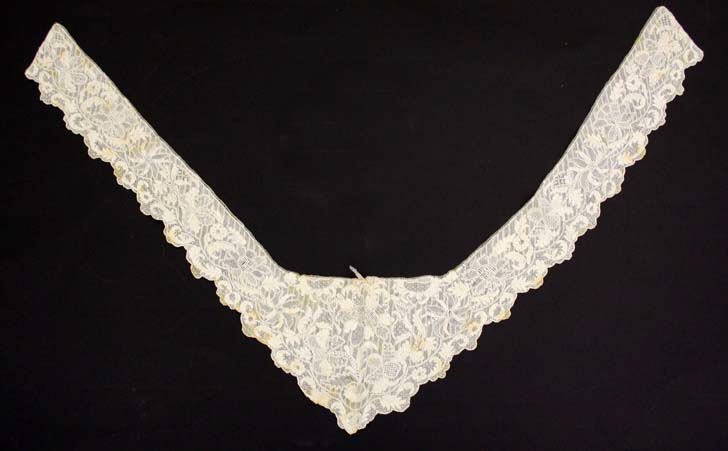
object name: collar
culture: british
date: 1701-1800